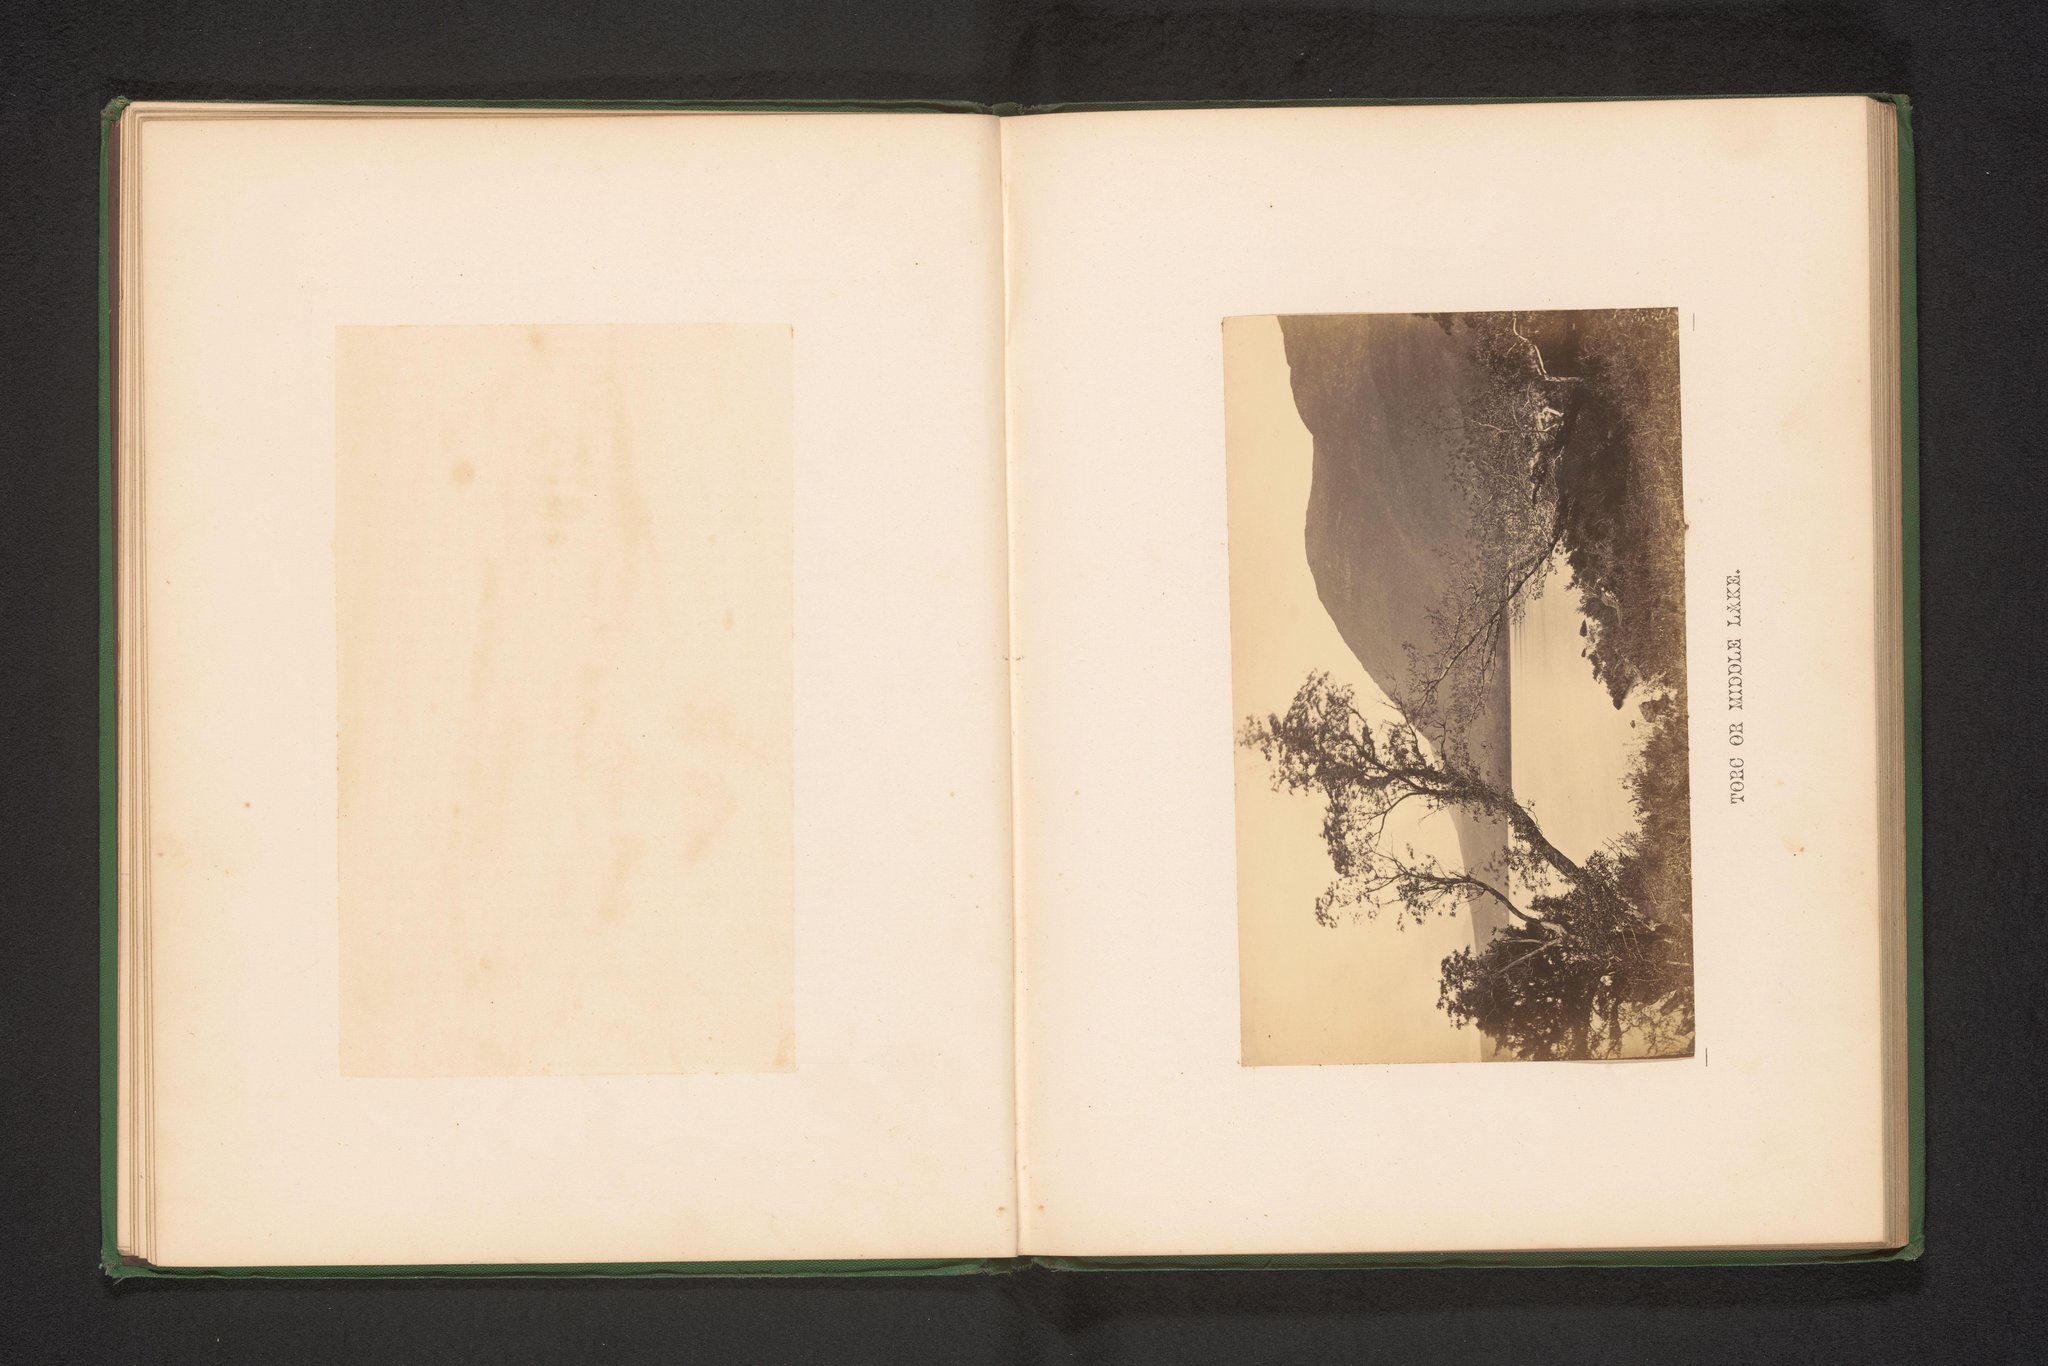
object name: photograph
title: Torc or Middel Lake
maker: john hudson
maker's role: fotograaf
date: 1862-1867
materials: photographic support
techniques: albumen print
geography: killarney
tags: landscapes with waters, waterscapes, seascapes (in the temperate zone), lake, mountains